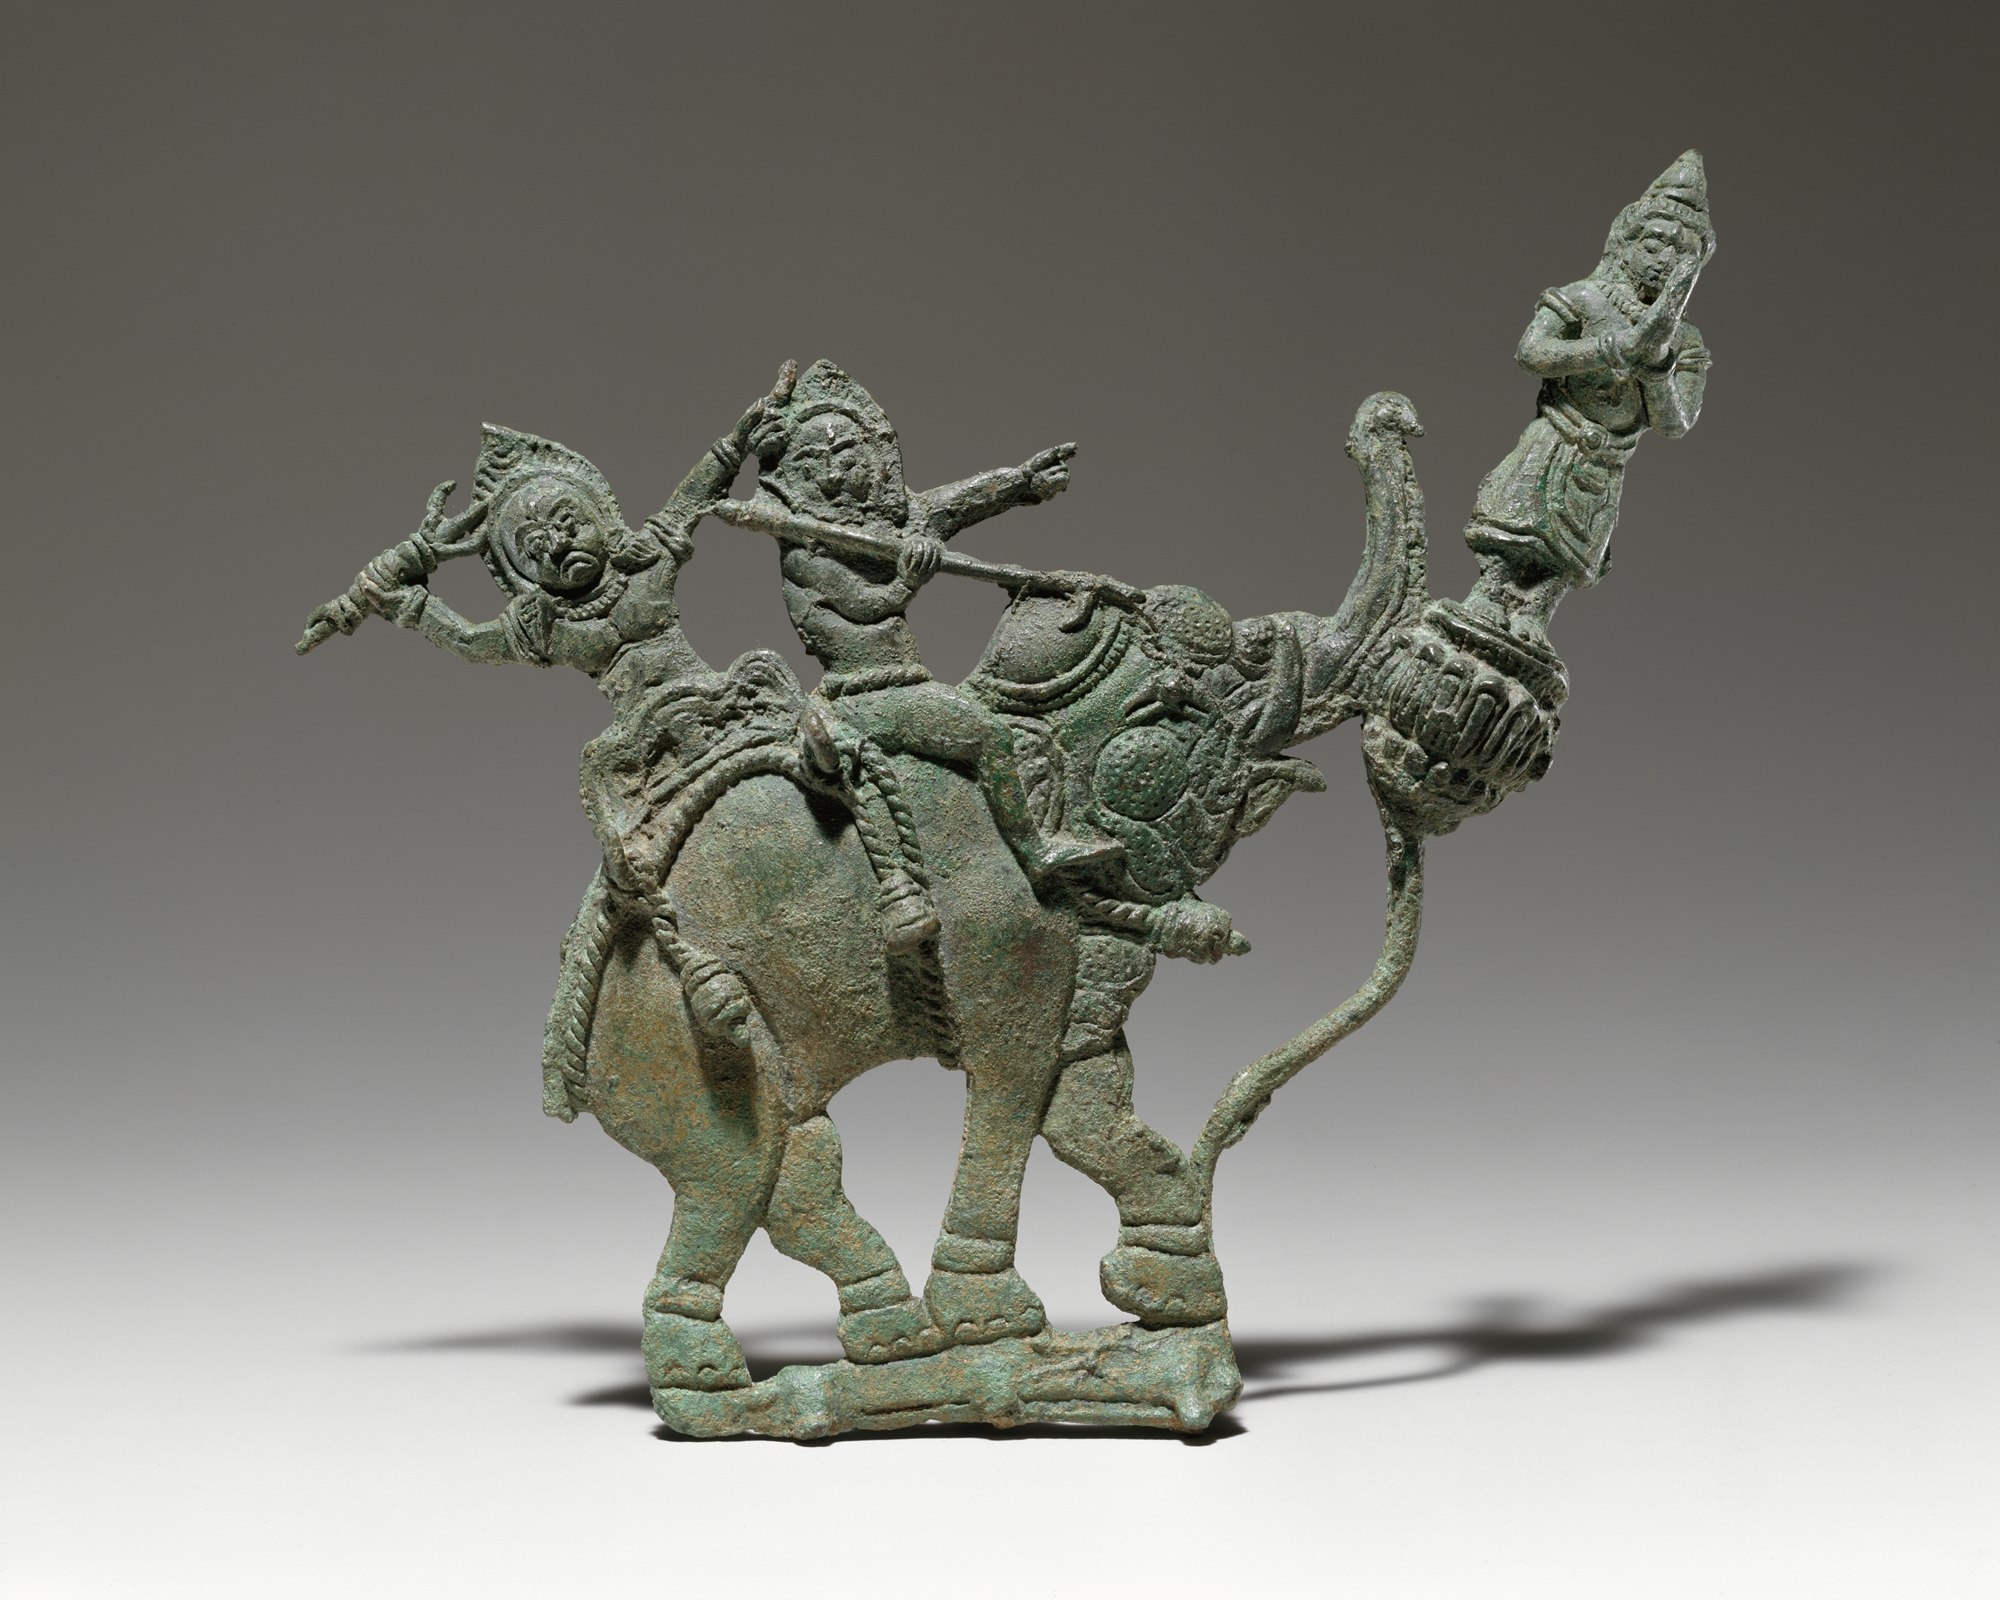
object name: plaque one of two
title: Demons on an Elephant with Adorant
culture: cambodian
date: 1167-1233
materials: bronze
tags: elephants,demons